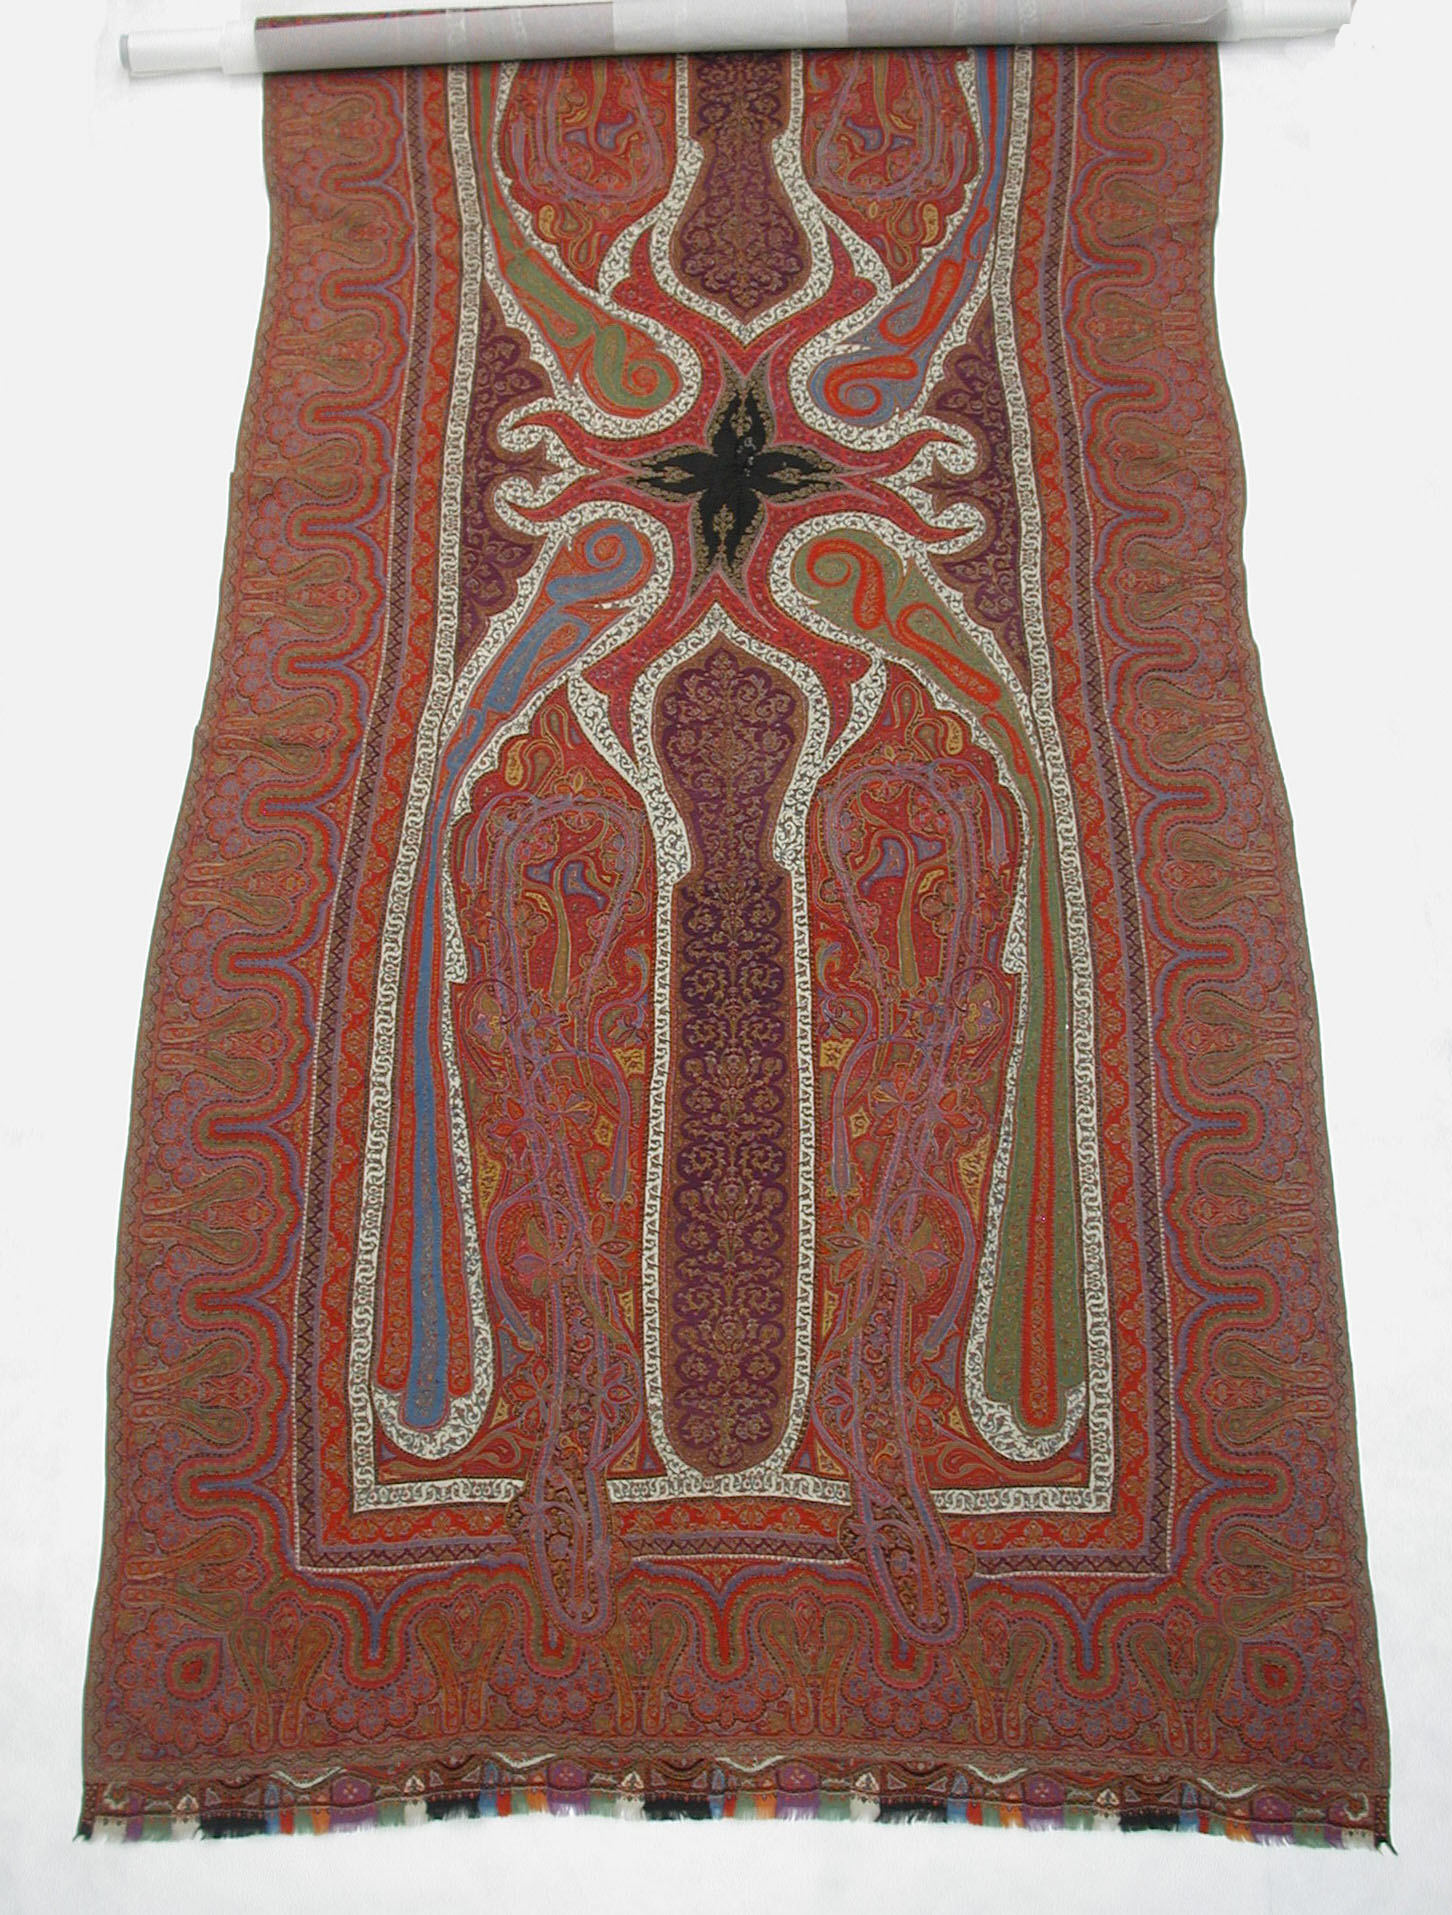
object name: cover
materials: silk, wool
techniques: embroidery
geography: india